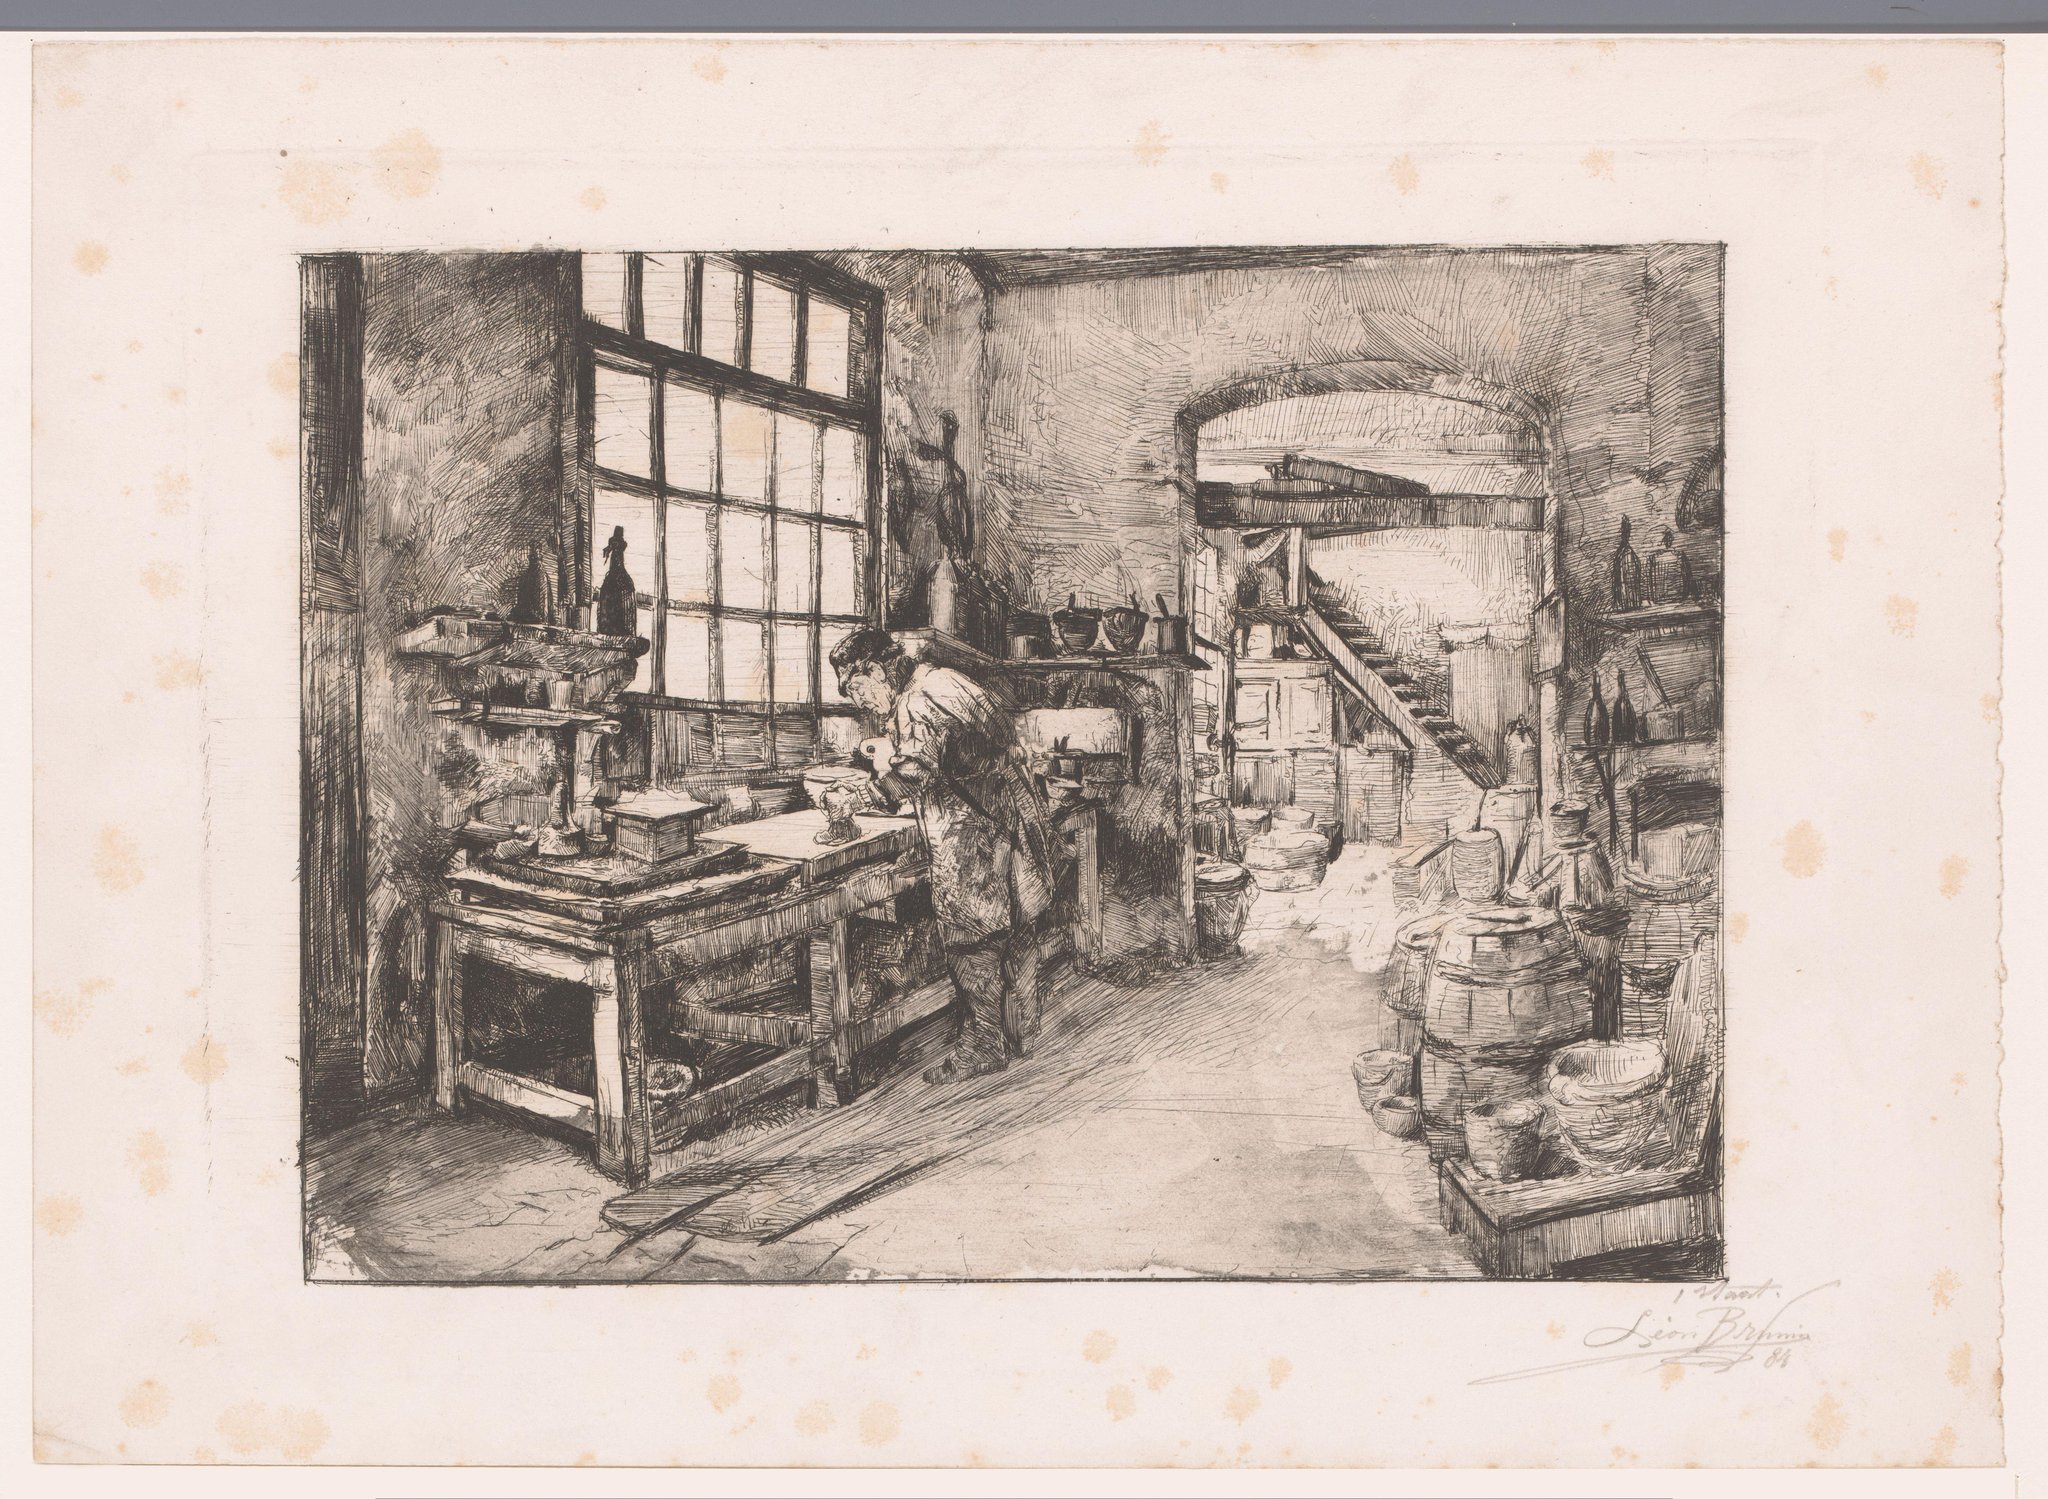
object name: print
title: Bereider van kleuren aan het werk in een atelier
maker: léon brunin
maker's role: print maker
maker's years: 1861-1949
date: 1884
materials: paper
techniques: etching, intaglio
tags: colours, pigments, and paints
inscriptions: collector's mark: Lugt 2228, annotation: ‘1 staat’